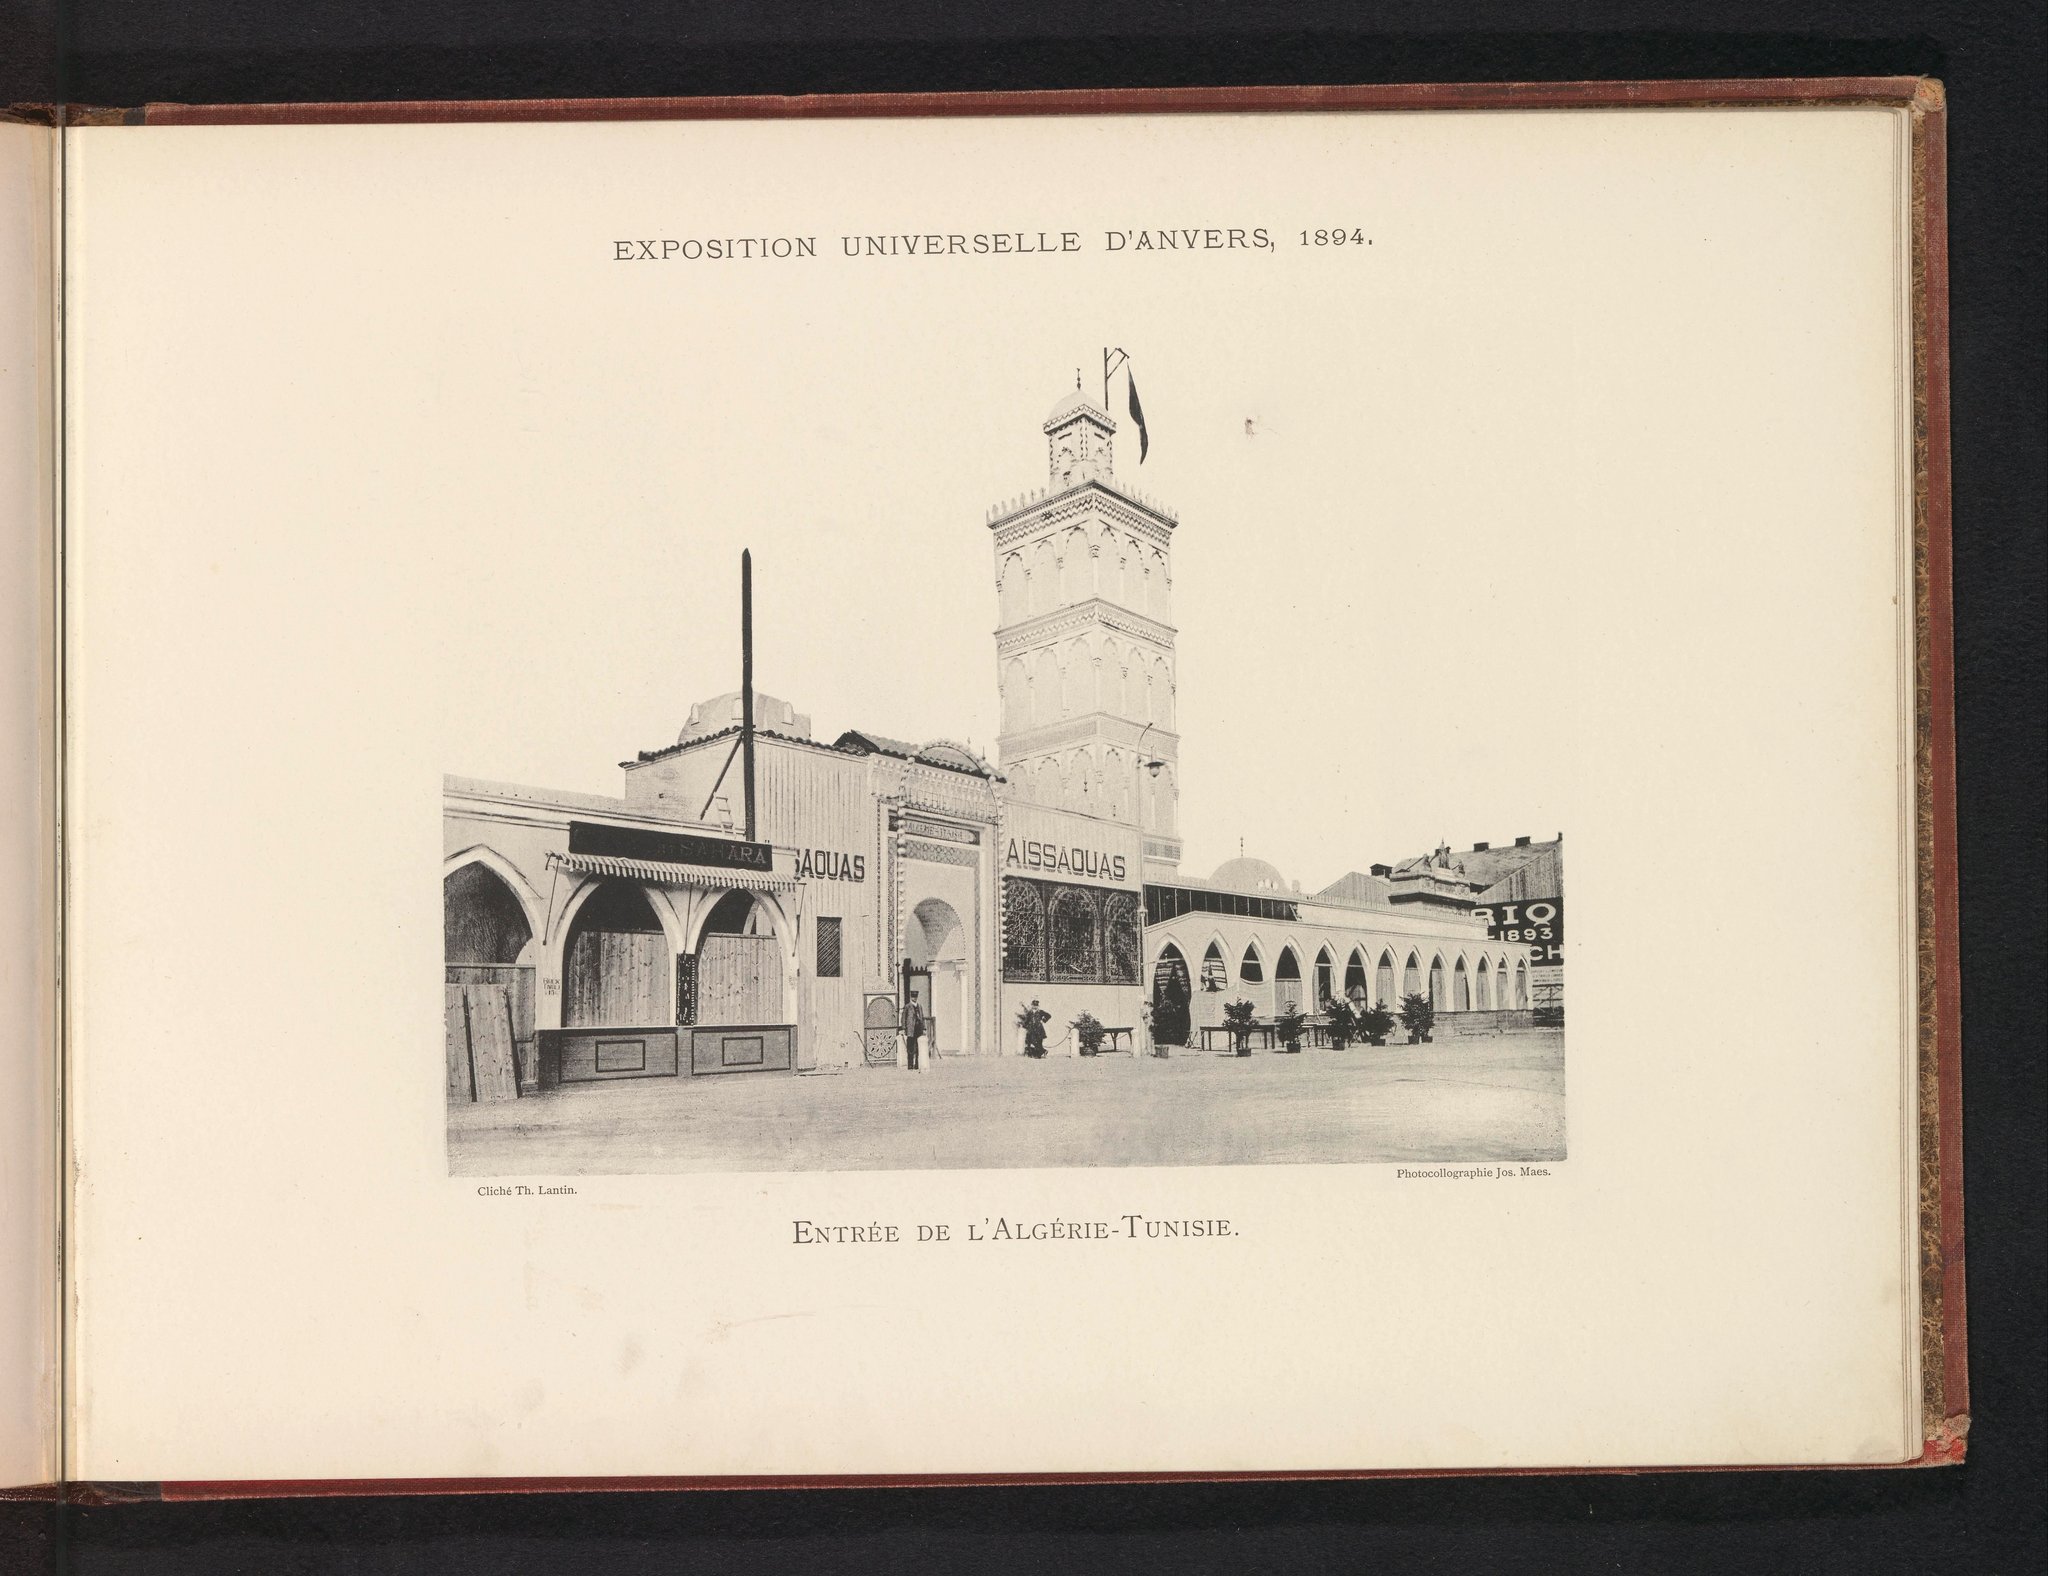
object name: photomechanical print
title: Entrée de l'Algérie-Tunisie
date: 1894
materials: paper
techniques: photograph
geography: antwerp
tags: world fair, world exhibition, façade (of house or building)